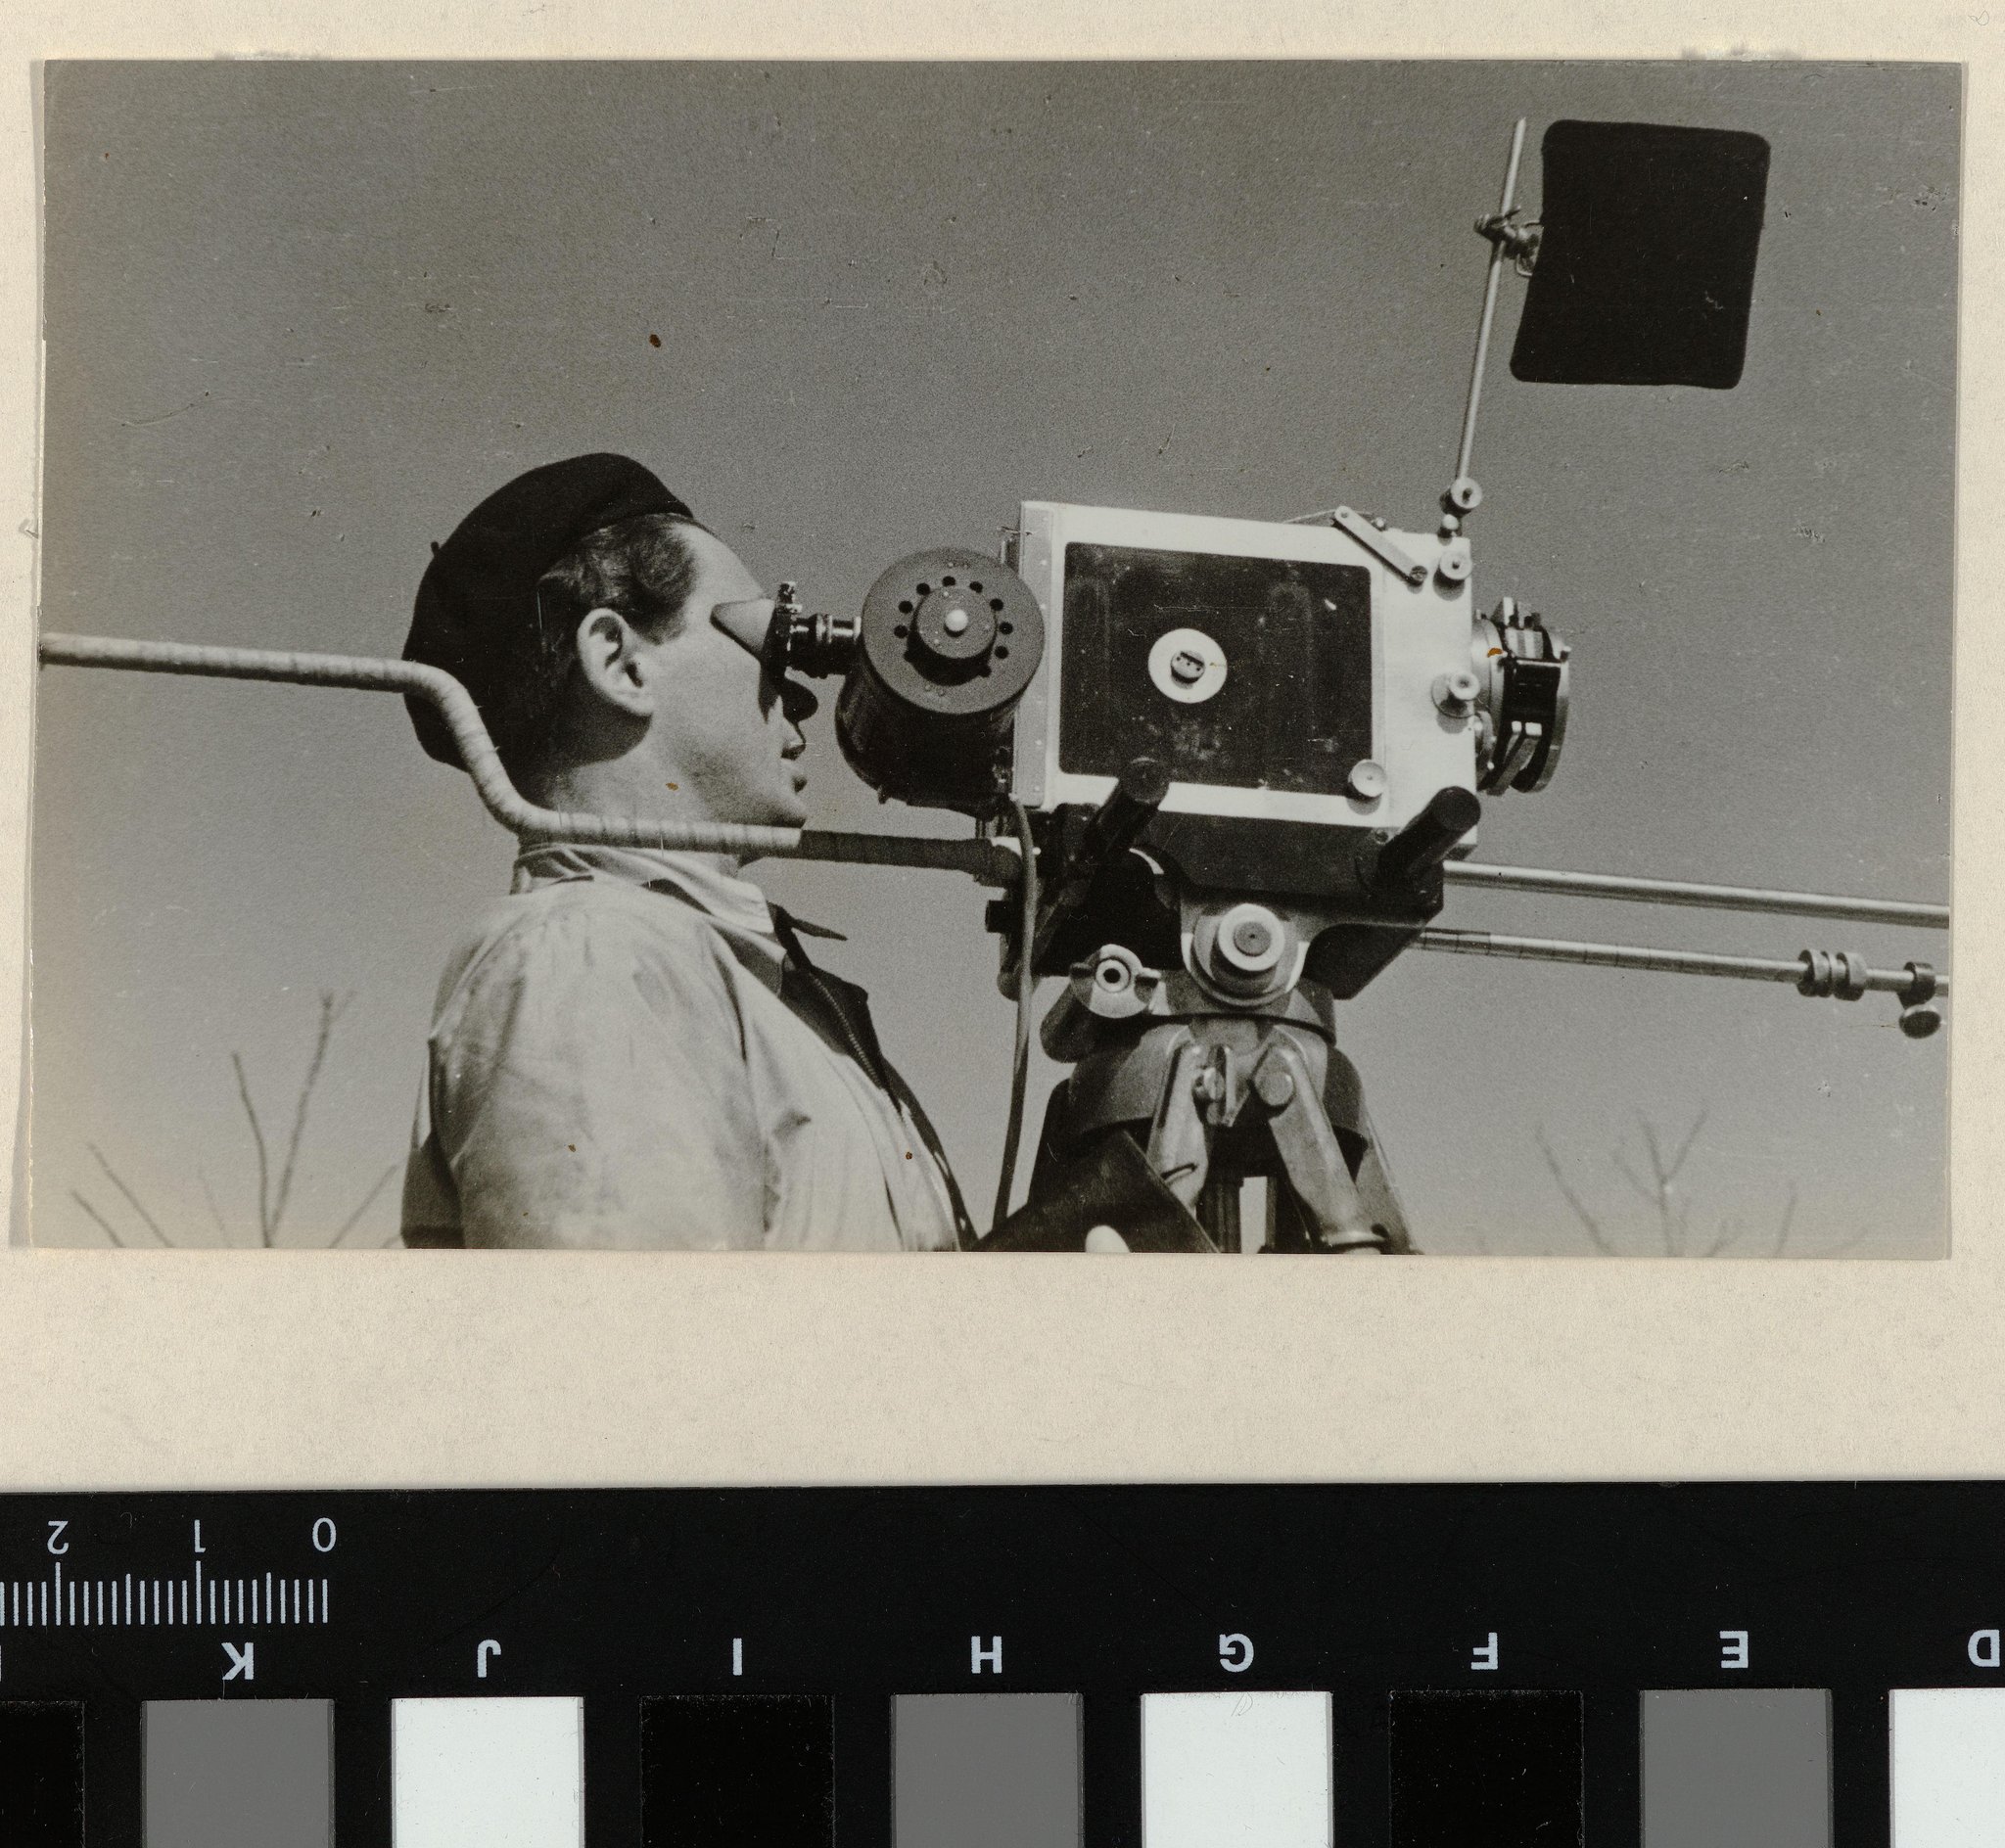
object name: photograph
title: Joris Ivens while filming The 400 Million in China | Cameraman John Fernhout setting up a camera in China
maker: robert capa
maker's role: fotograaf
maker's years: 1913-1954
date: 1938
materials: paper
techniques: gelatin silver print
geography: china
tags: paris, joris ivens, filming, cinematographer at work - cc - out of doors, china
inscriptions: stamp: ‘B 404’